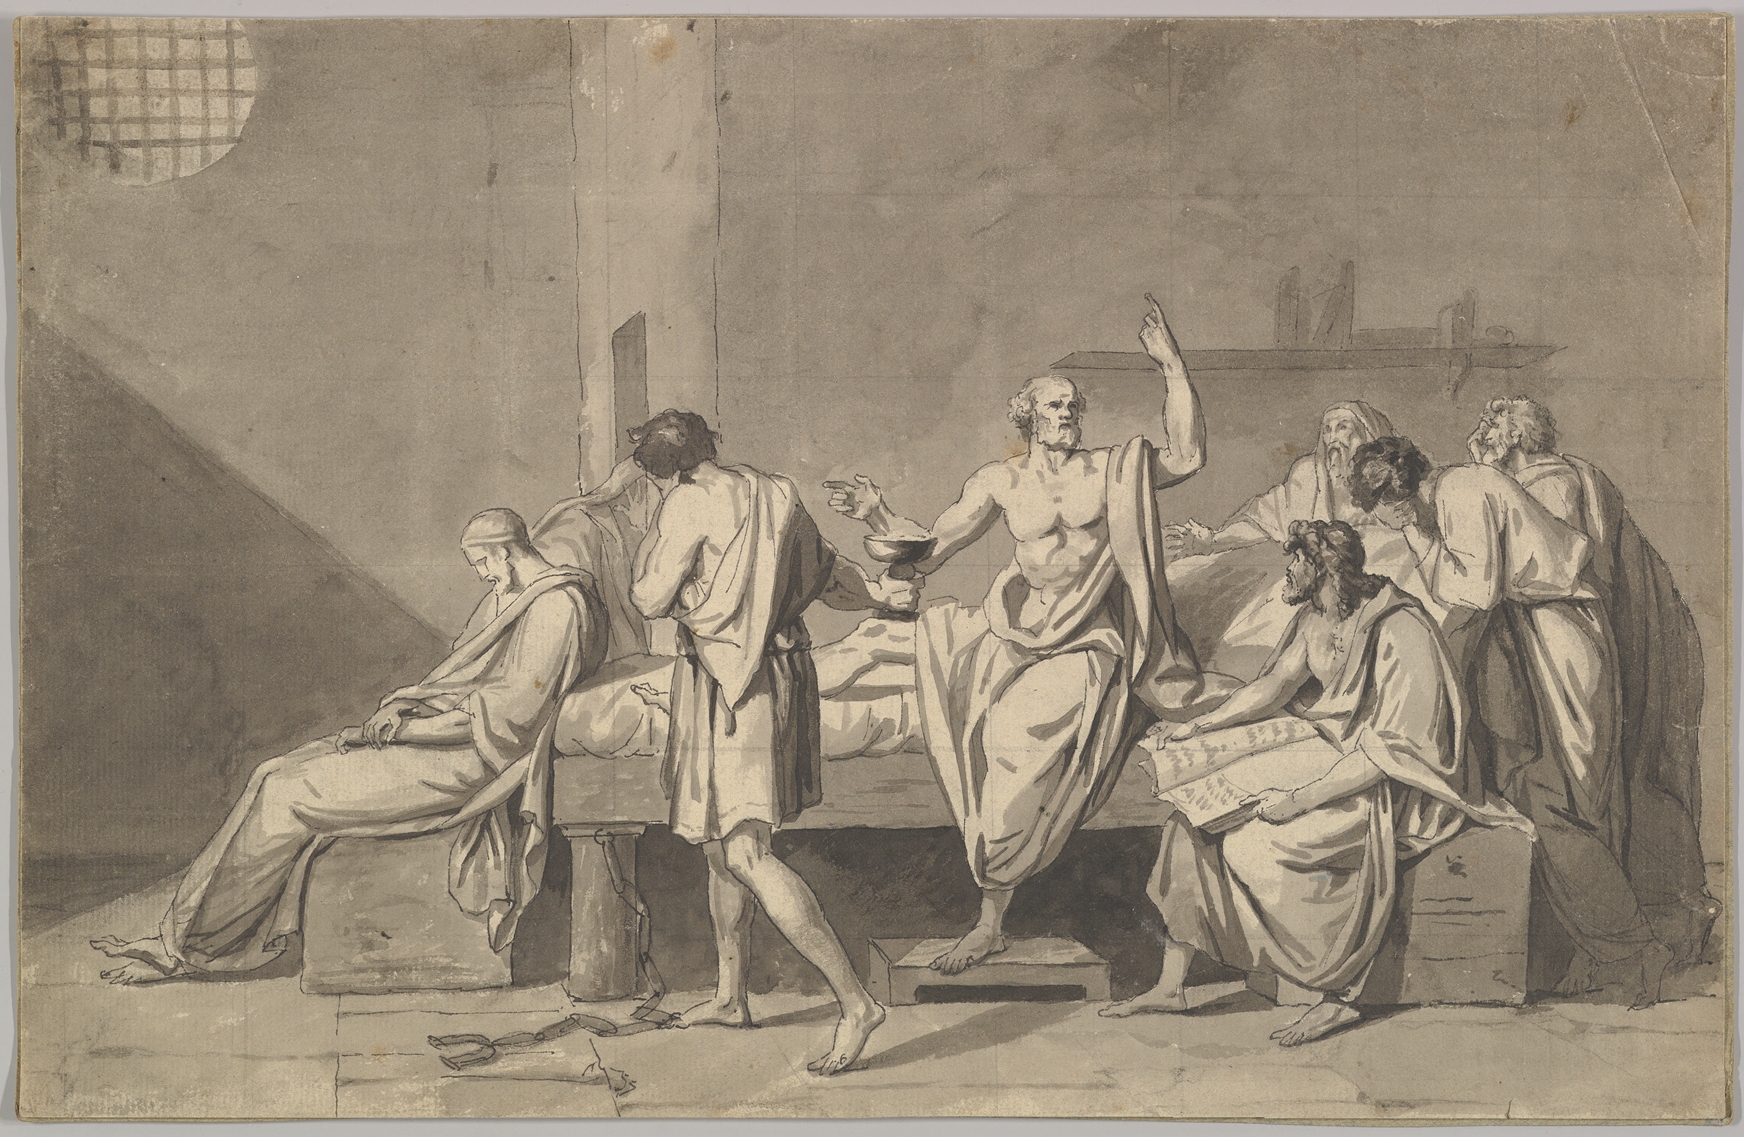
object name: drawing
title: The Death of Socrates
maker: jacques louis david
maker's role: artist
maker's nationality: french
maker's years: 1748-1825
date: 1782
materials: chalk, ink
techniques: brush, pen, drawing, wash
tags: prisons,socrates,men,death